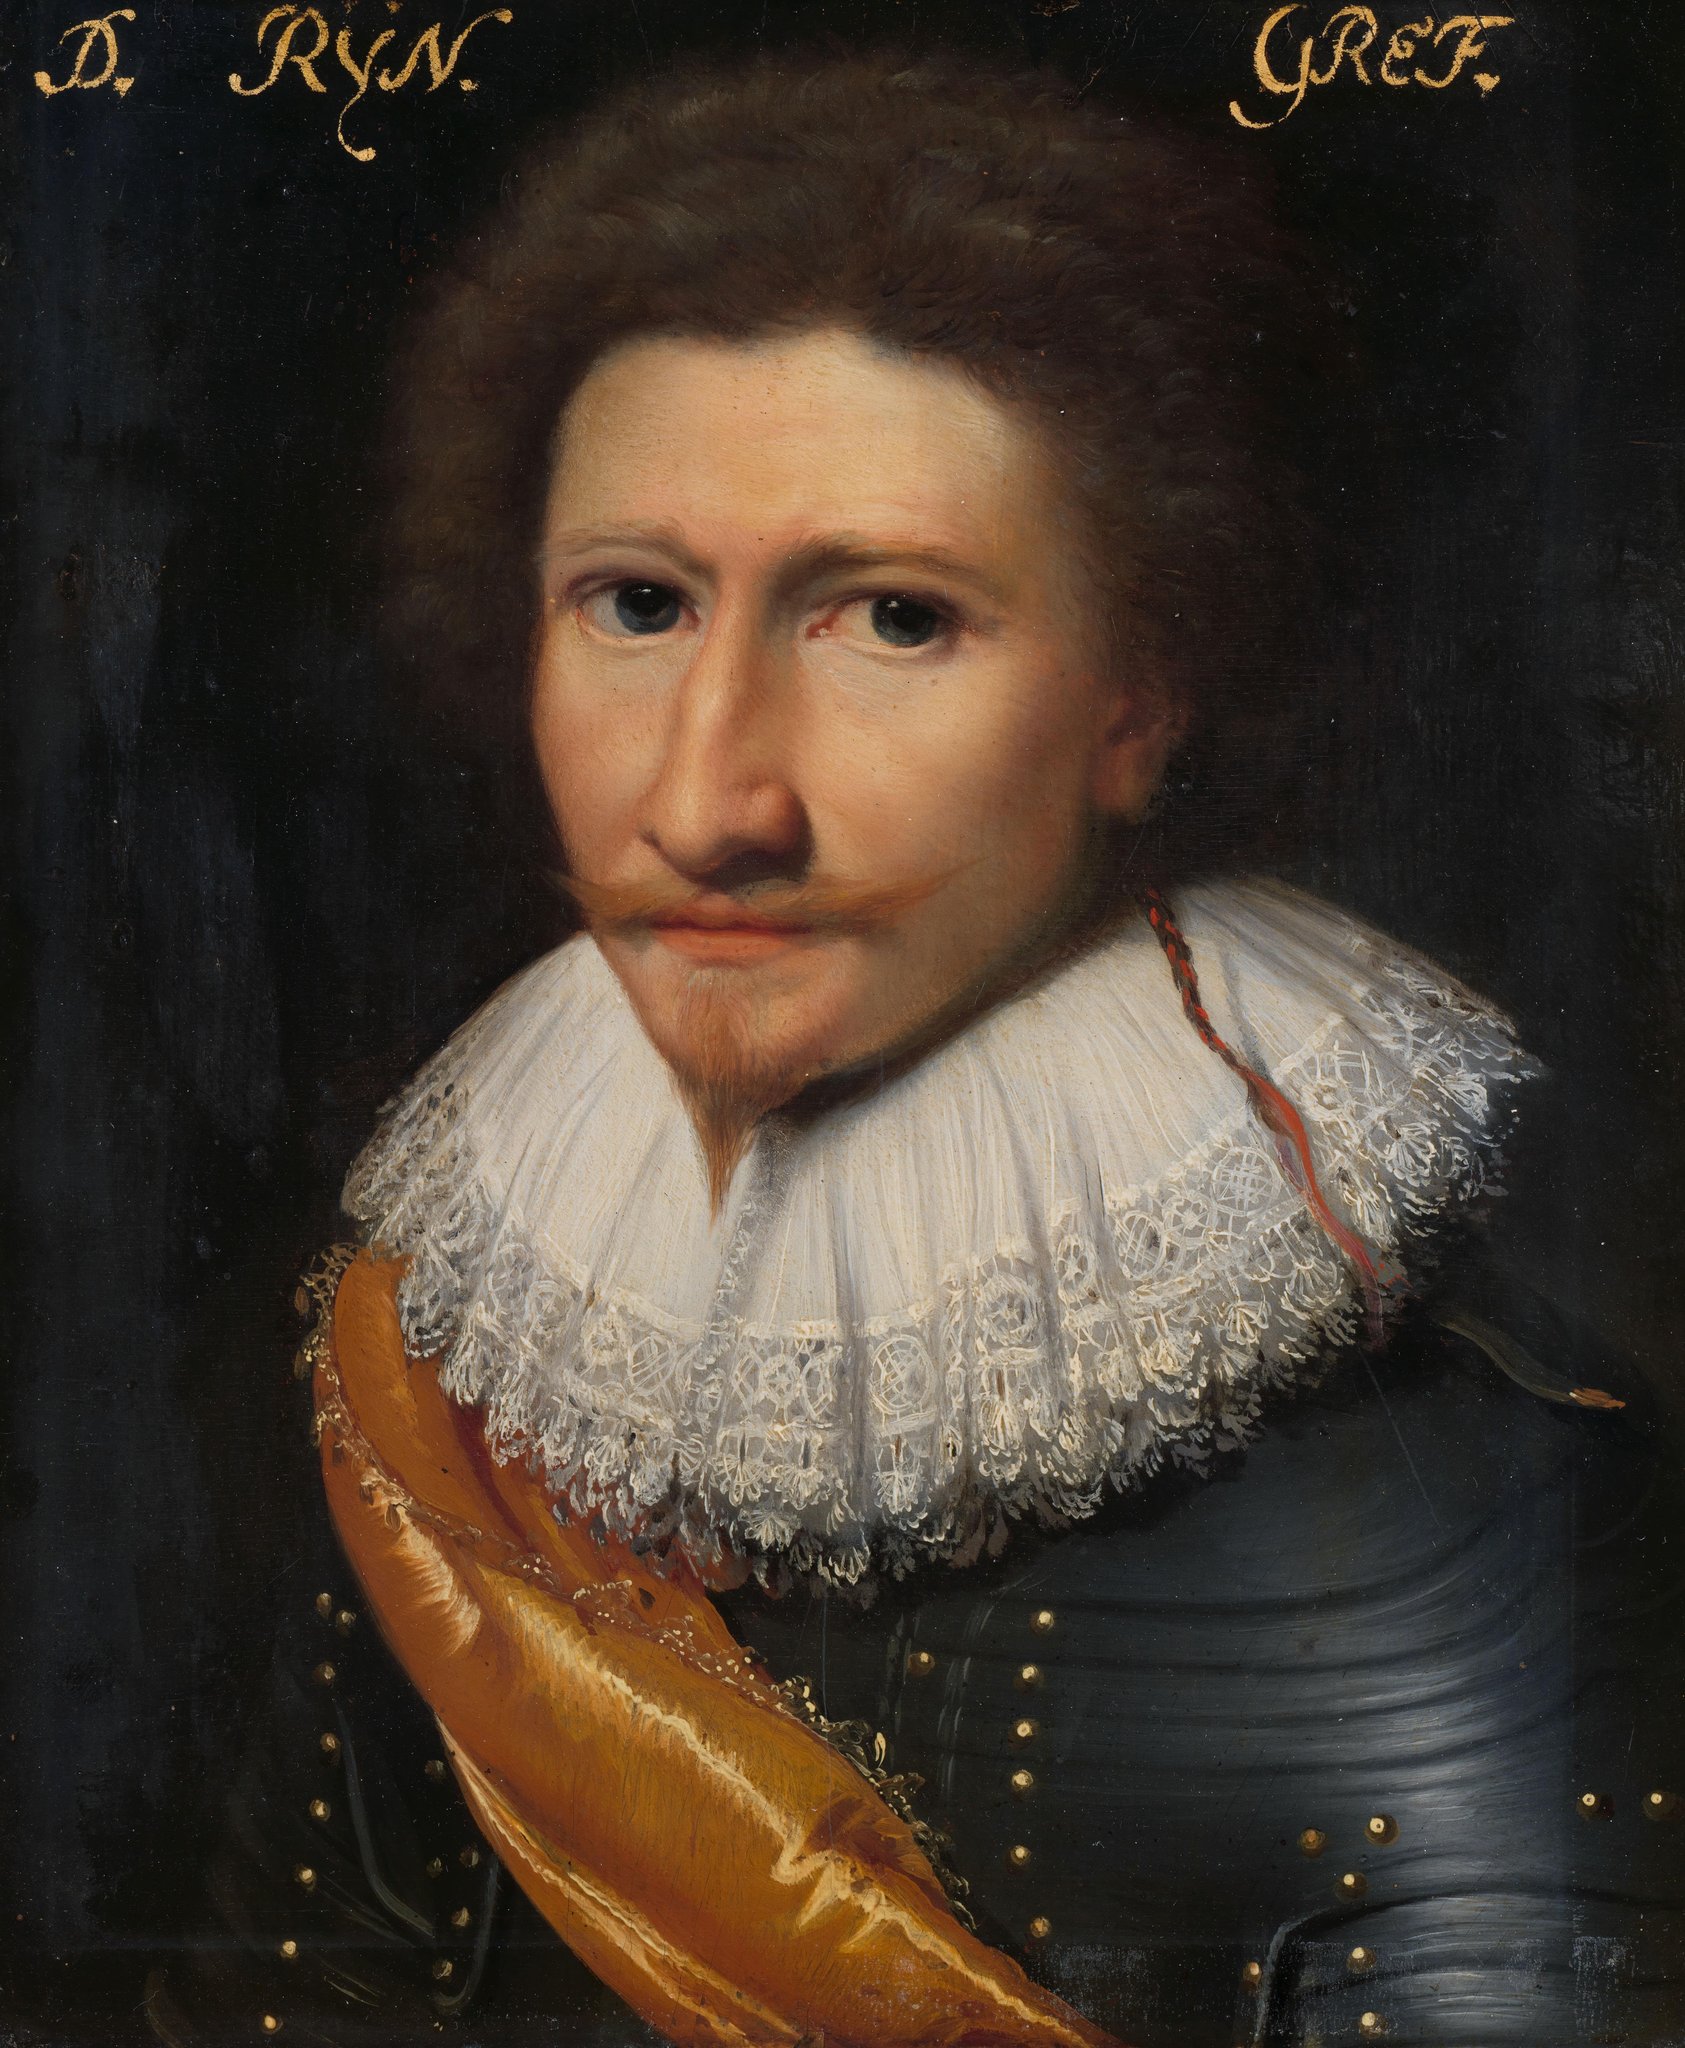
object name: painting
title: Portrait of Johann Conrad von Salm (1590-1625), Waldgrave and Rhinegrave of Dhaun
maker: jan antonisz van ravesteyn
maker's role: draughtsman, painter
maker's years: 1570-1657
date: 1622-1625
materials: oil, panel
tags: historical persons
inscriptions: inscription, top right: ‘GREF.’, inscription, top left: ‘D. RIJN.’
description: Jan Coenraad van Salm (1590- 1622), Wild- en Rijngraaf van het Heilige Roomse Rijk, door W. de Geest.